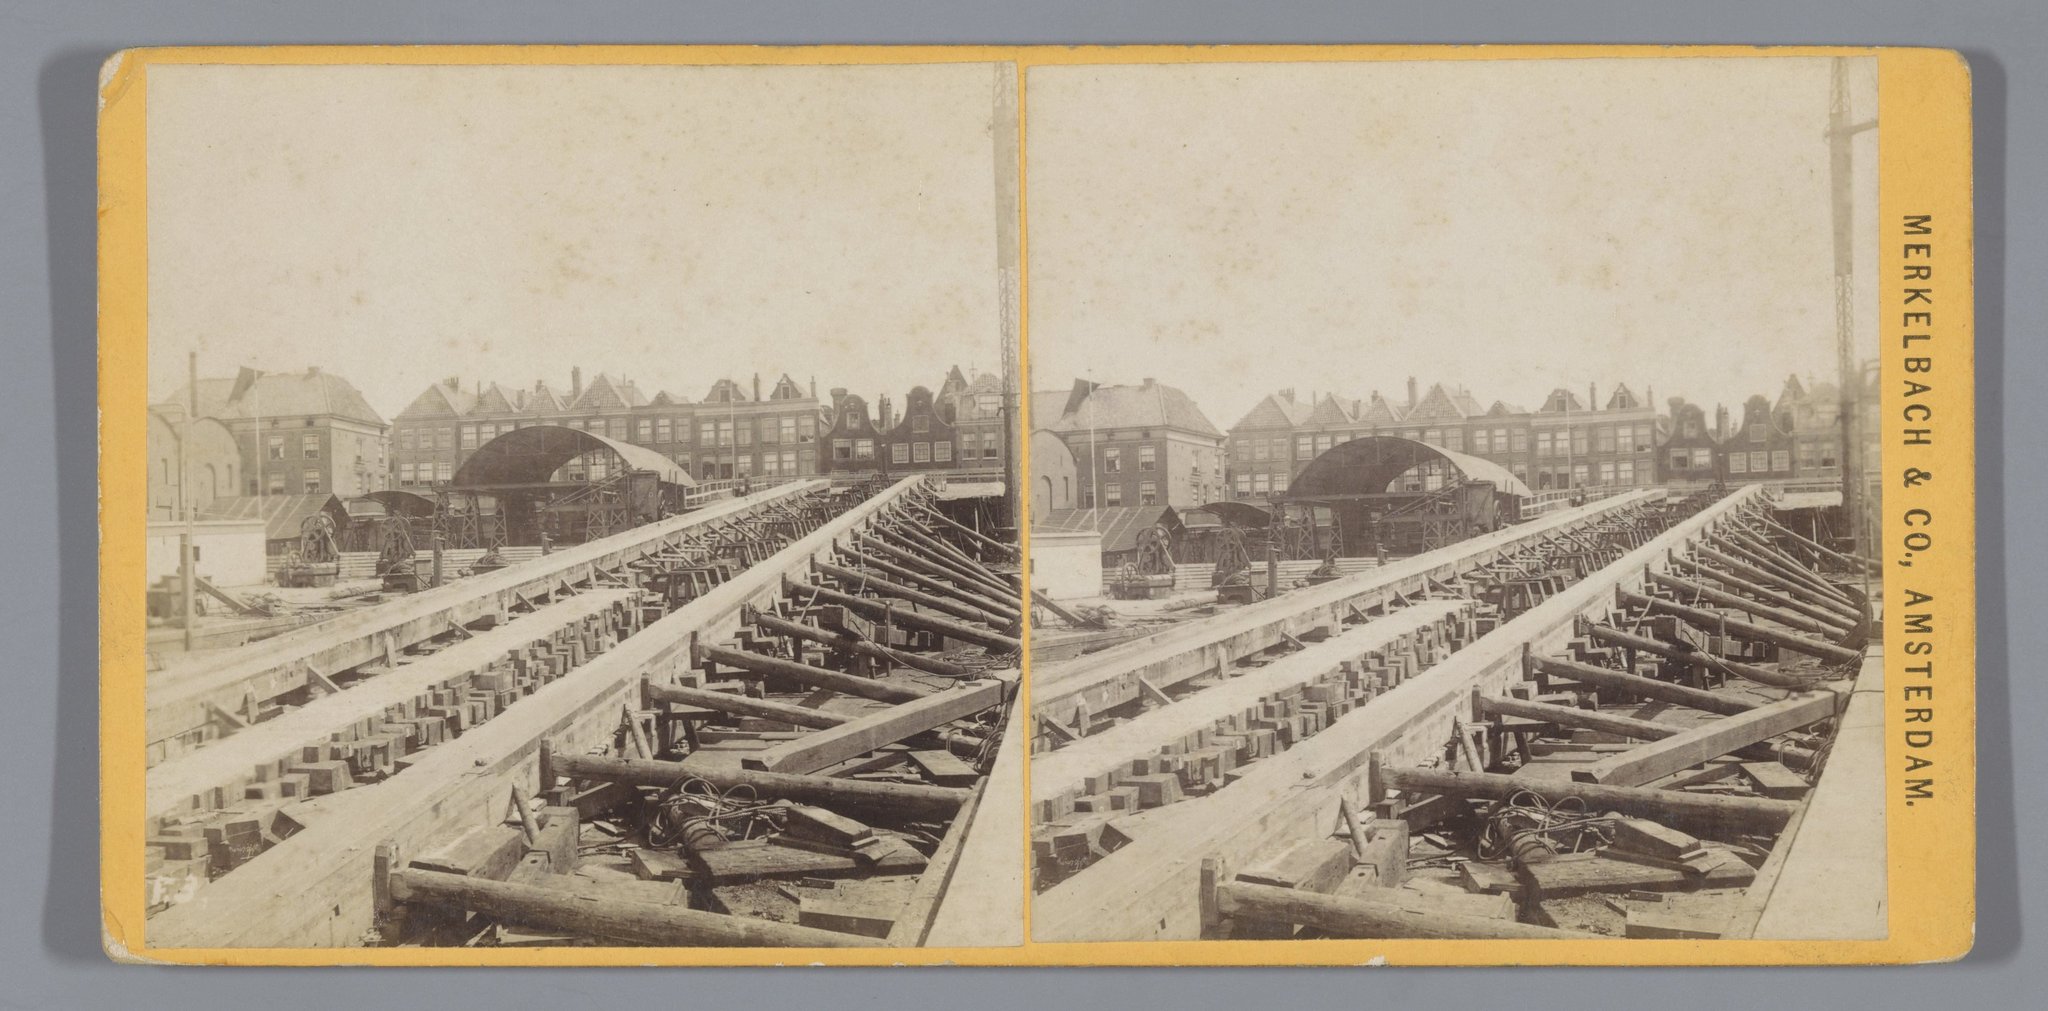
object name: stereograph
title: Een helling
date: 1900-1902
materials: cardboard, paper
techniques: albumen print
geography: amsterdam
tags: dry-dock, floating-dock, pier, quay, wharf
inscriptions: inscription: ‘F.3.’, inscription: ‘aan 's Rijks Marinewerf te Amsterdam (...) lang.’, number: ‘3.’, inscription: ‘Scheepsbouwwerf’